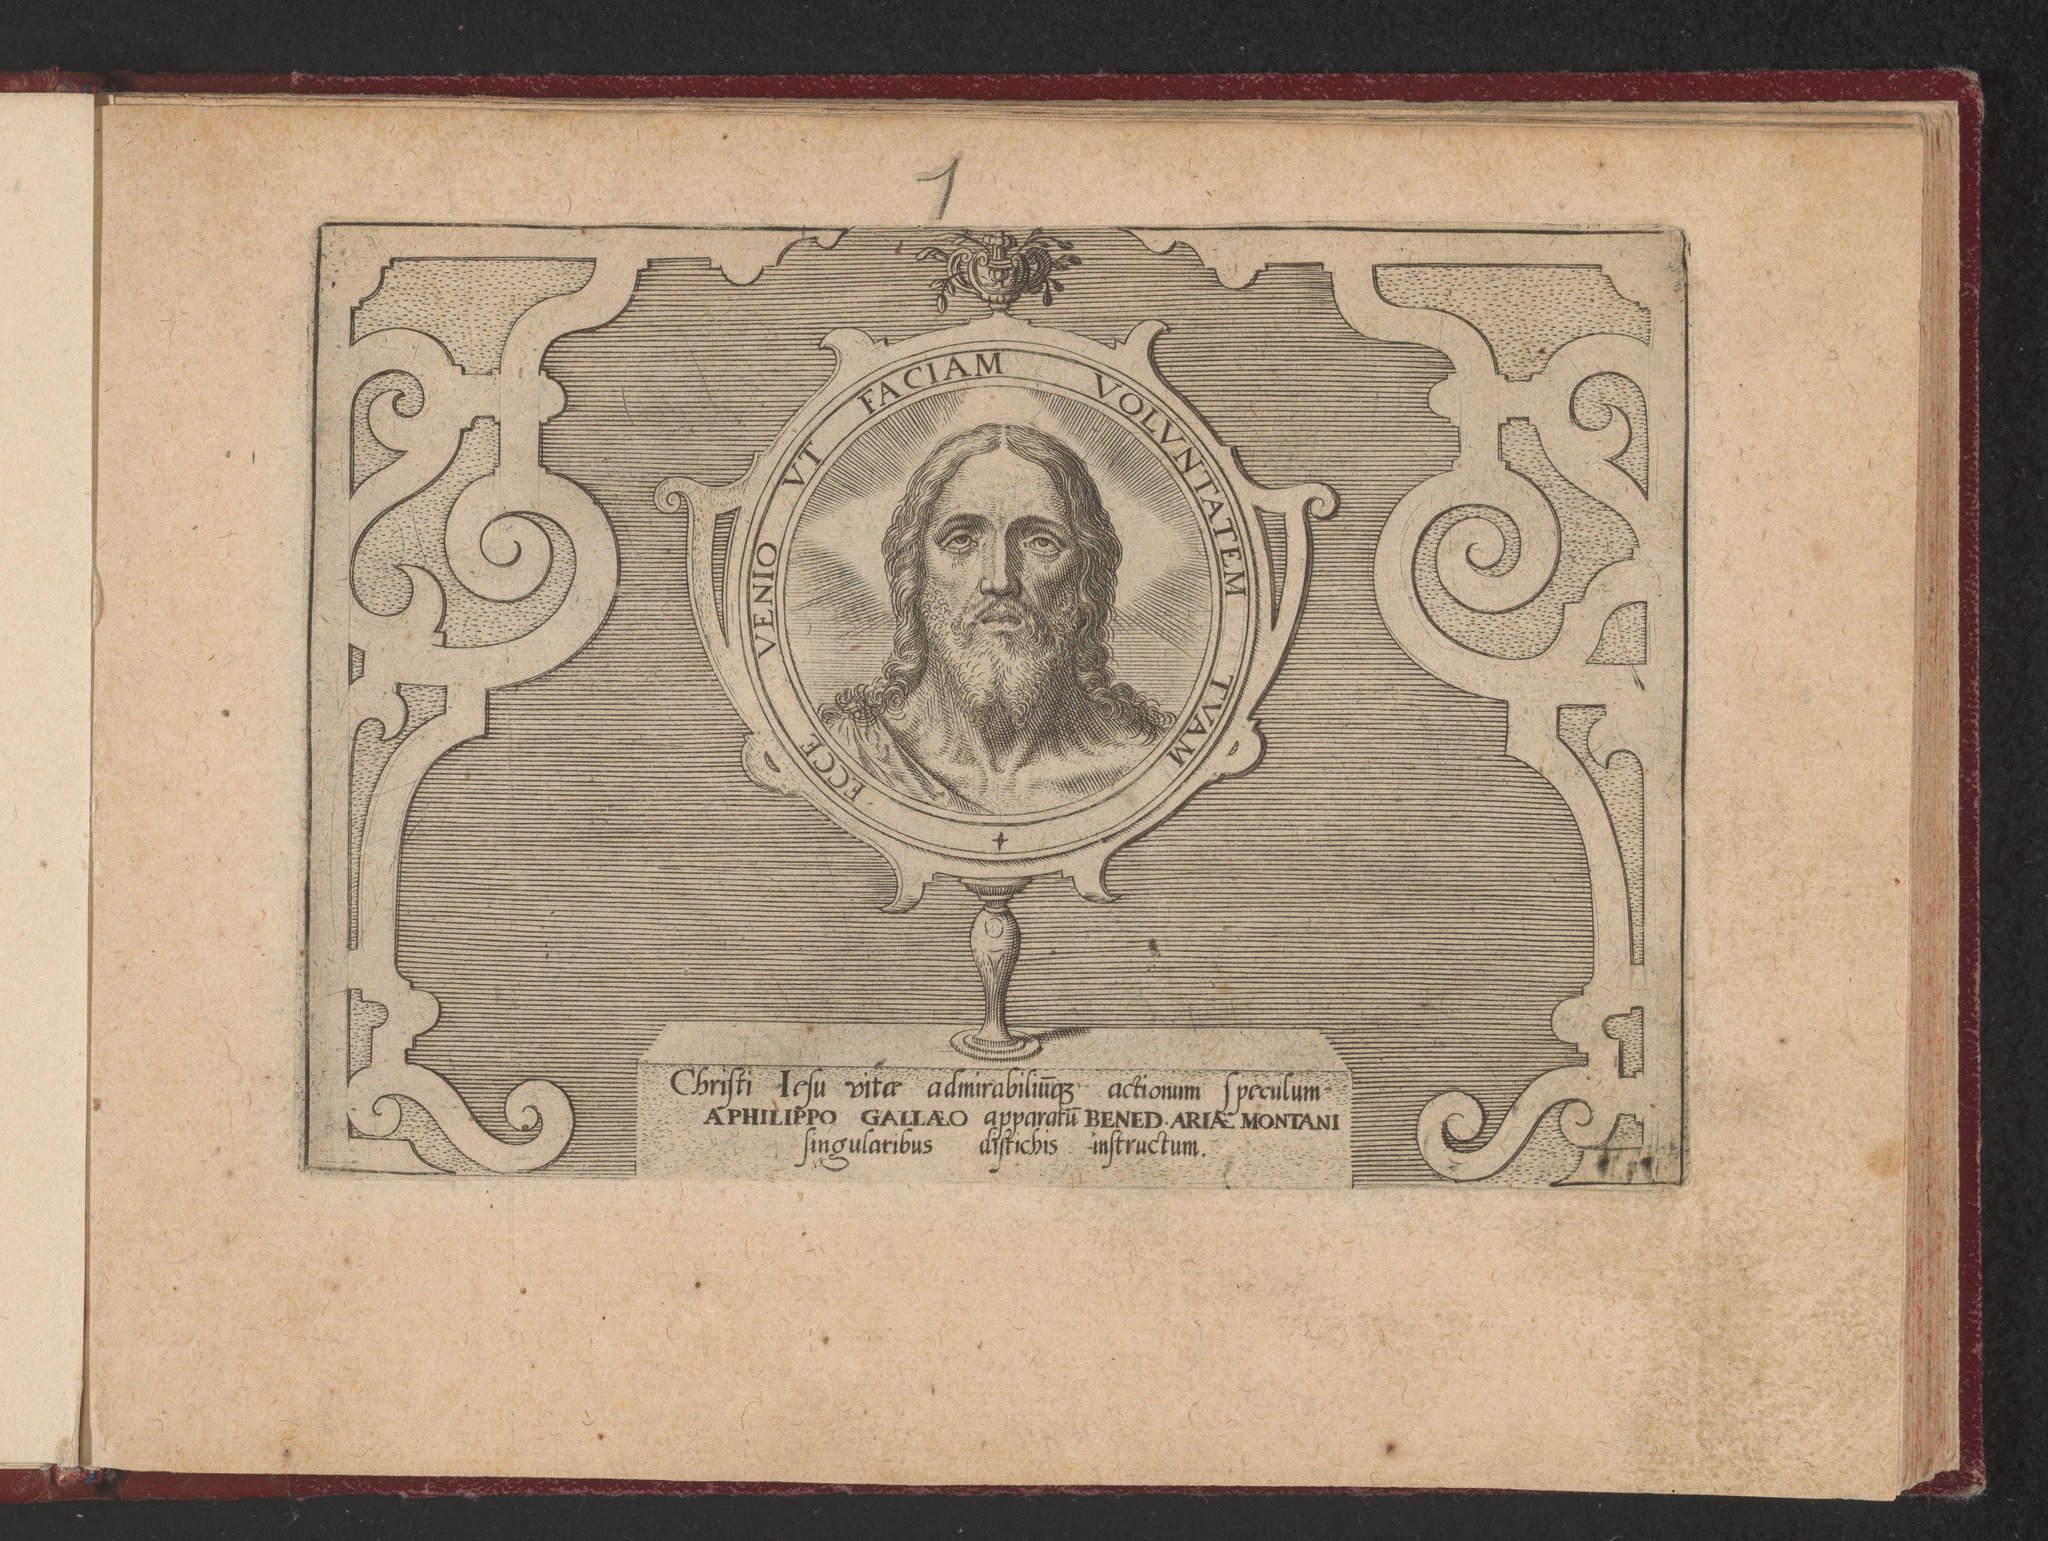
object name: print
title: Annunciatie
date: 1573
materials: paper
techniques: engraving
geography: antwerp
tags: the annunciation: mary sitting - aa - mary to the left, the angel to the right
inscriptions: watermark: ‘gotische letter P’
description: Onderdeel van een album met een titelprent en een serie van 50 prenten betreffende het leven en de passie van Christus.